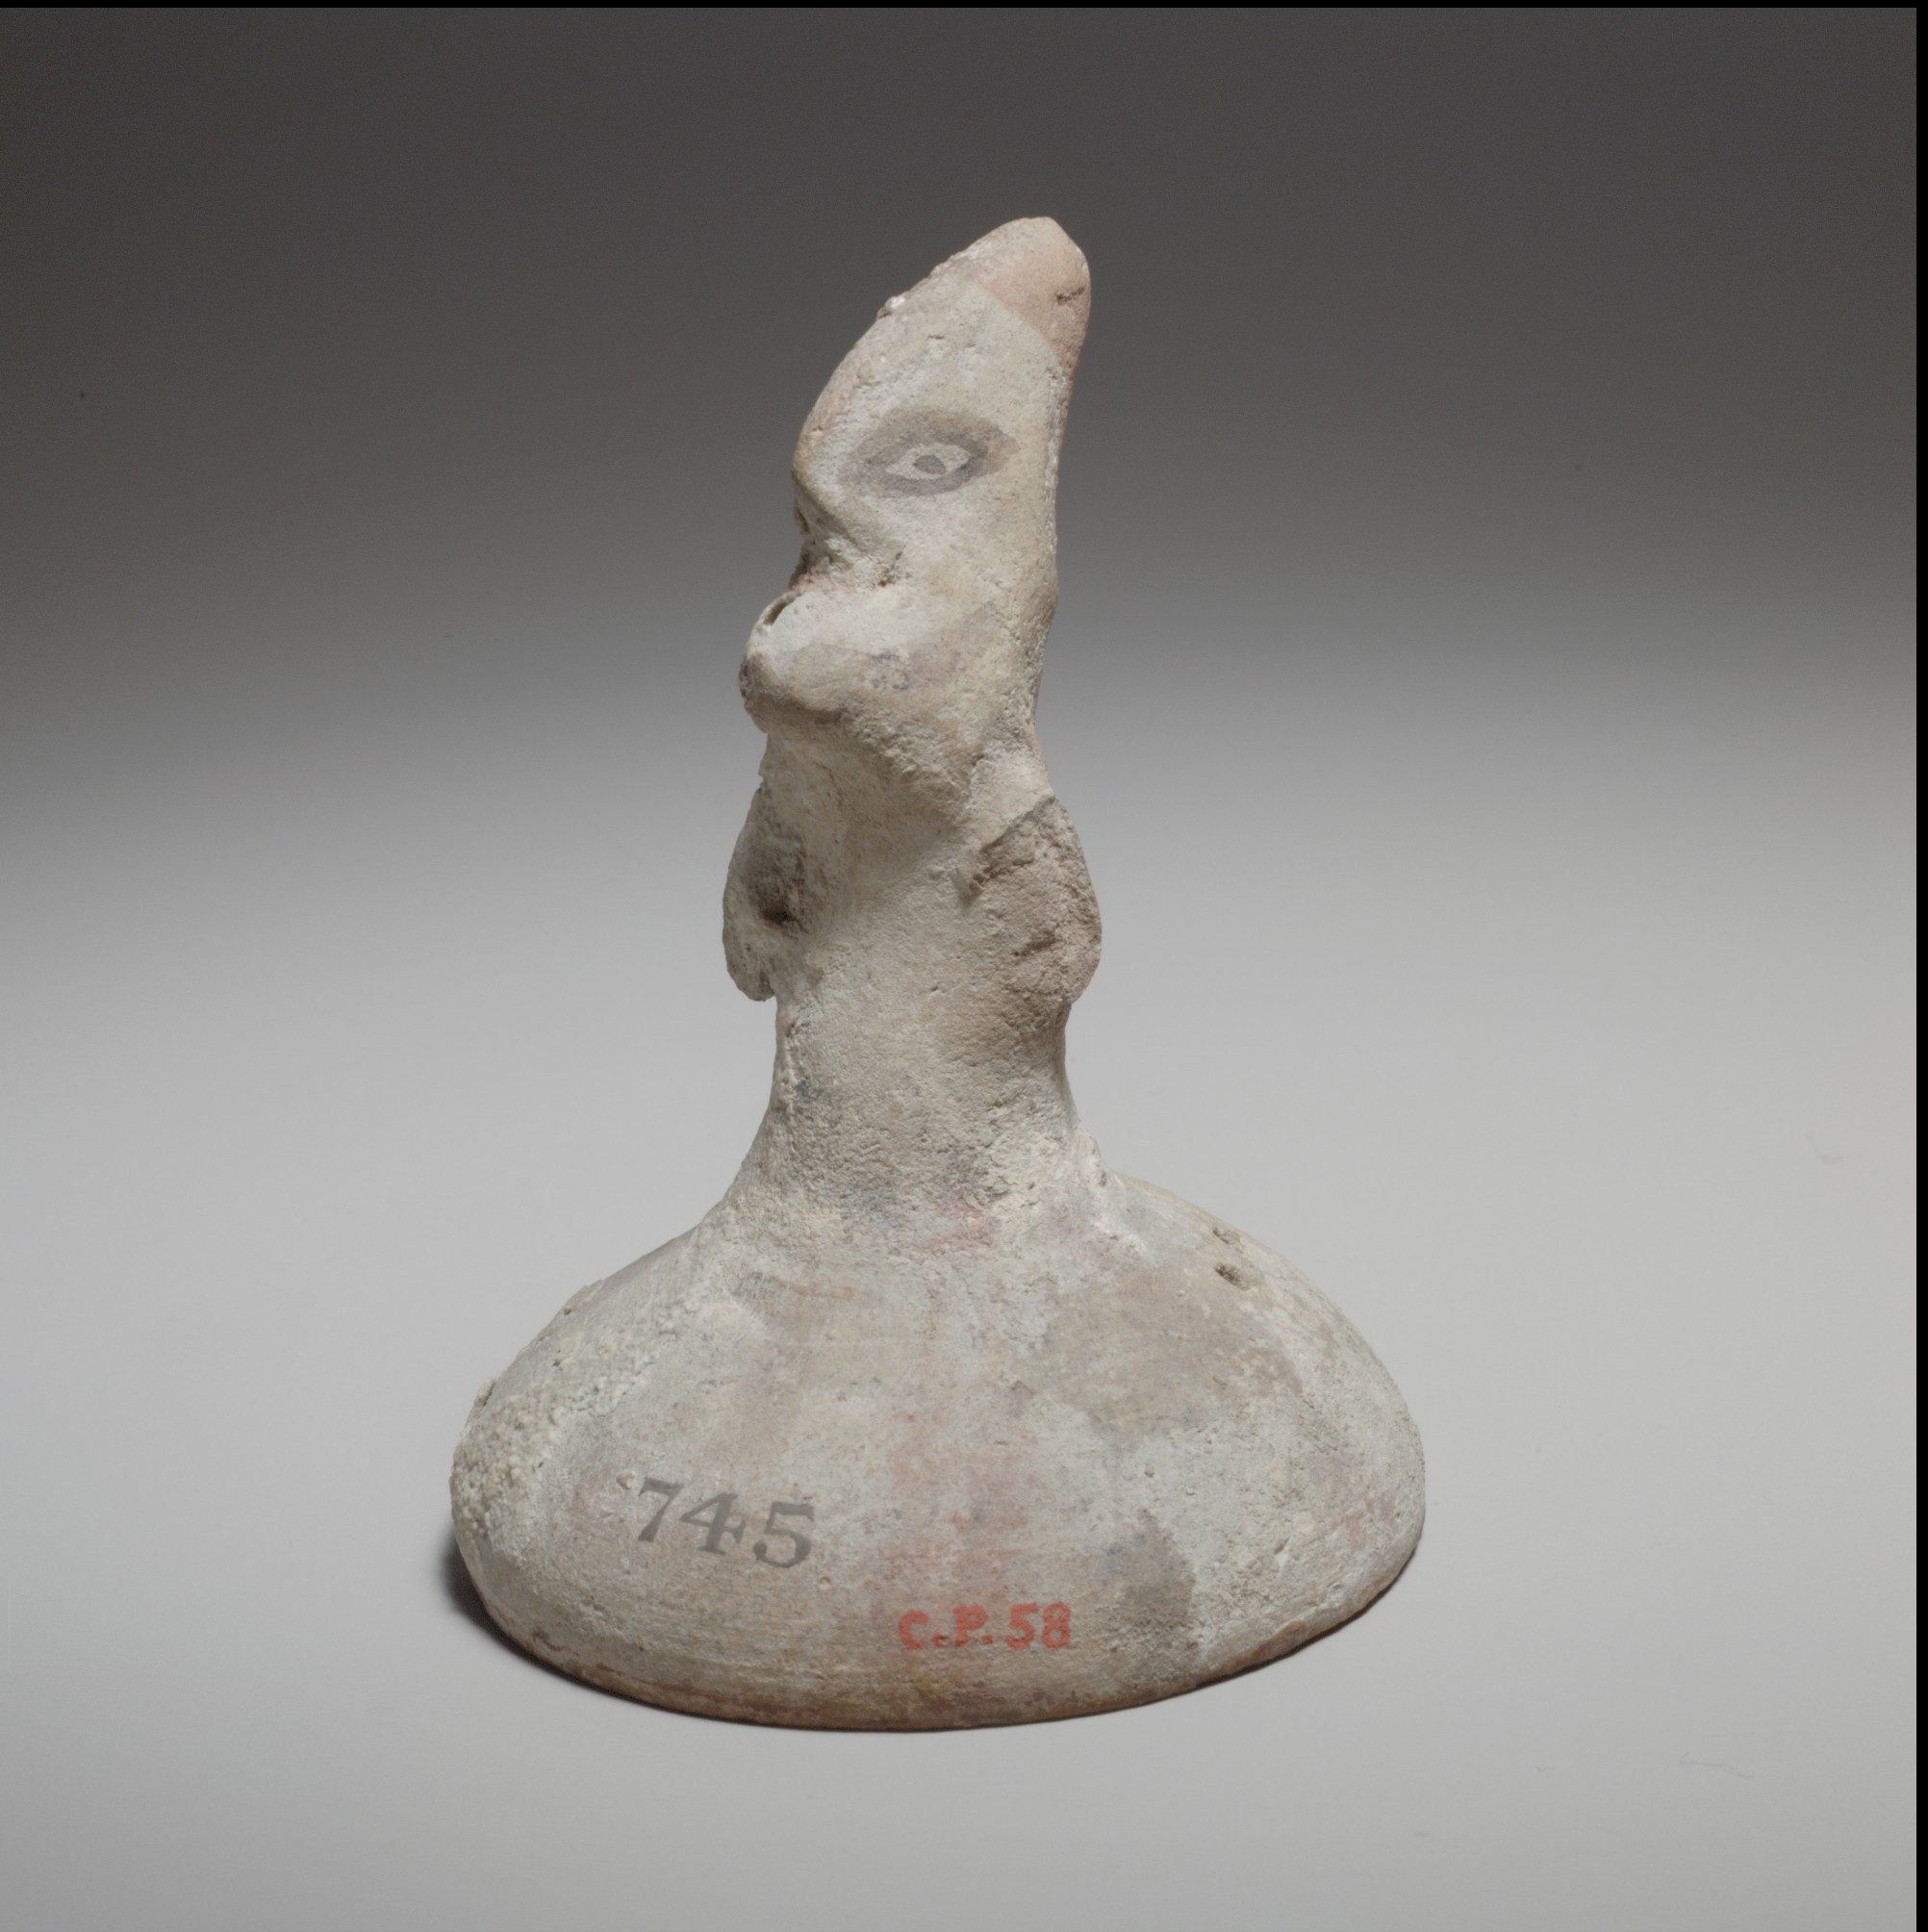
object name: bell with handle in form of human figure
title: Standing male figurine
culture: cypriot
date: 750-600 BCE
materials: terracotta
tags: men